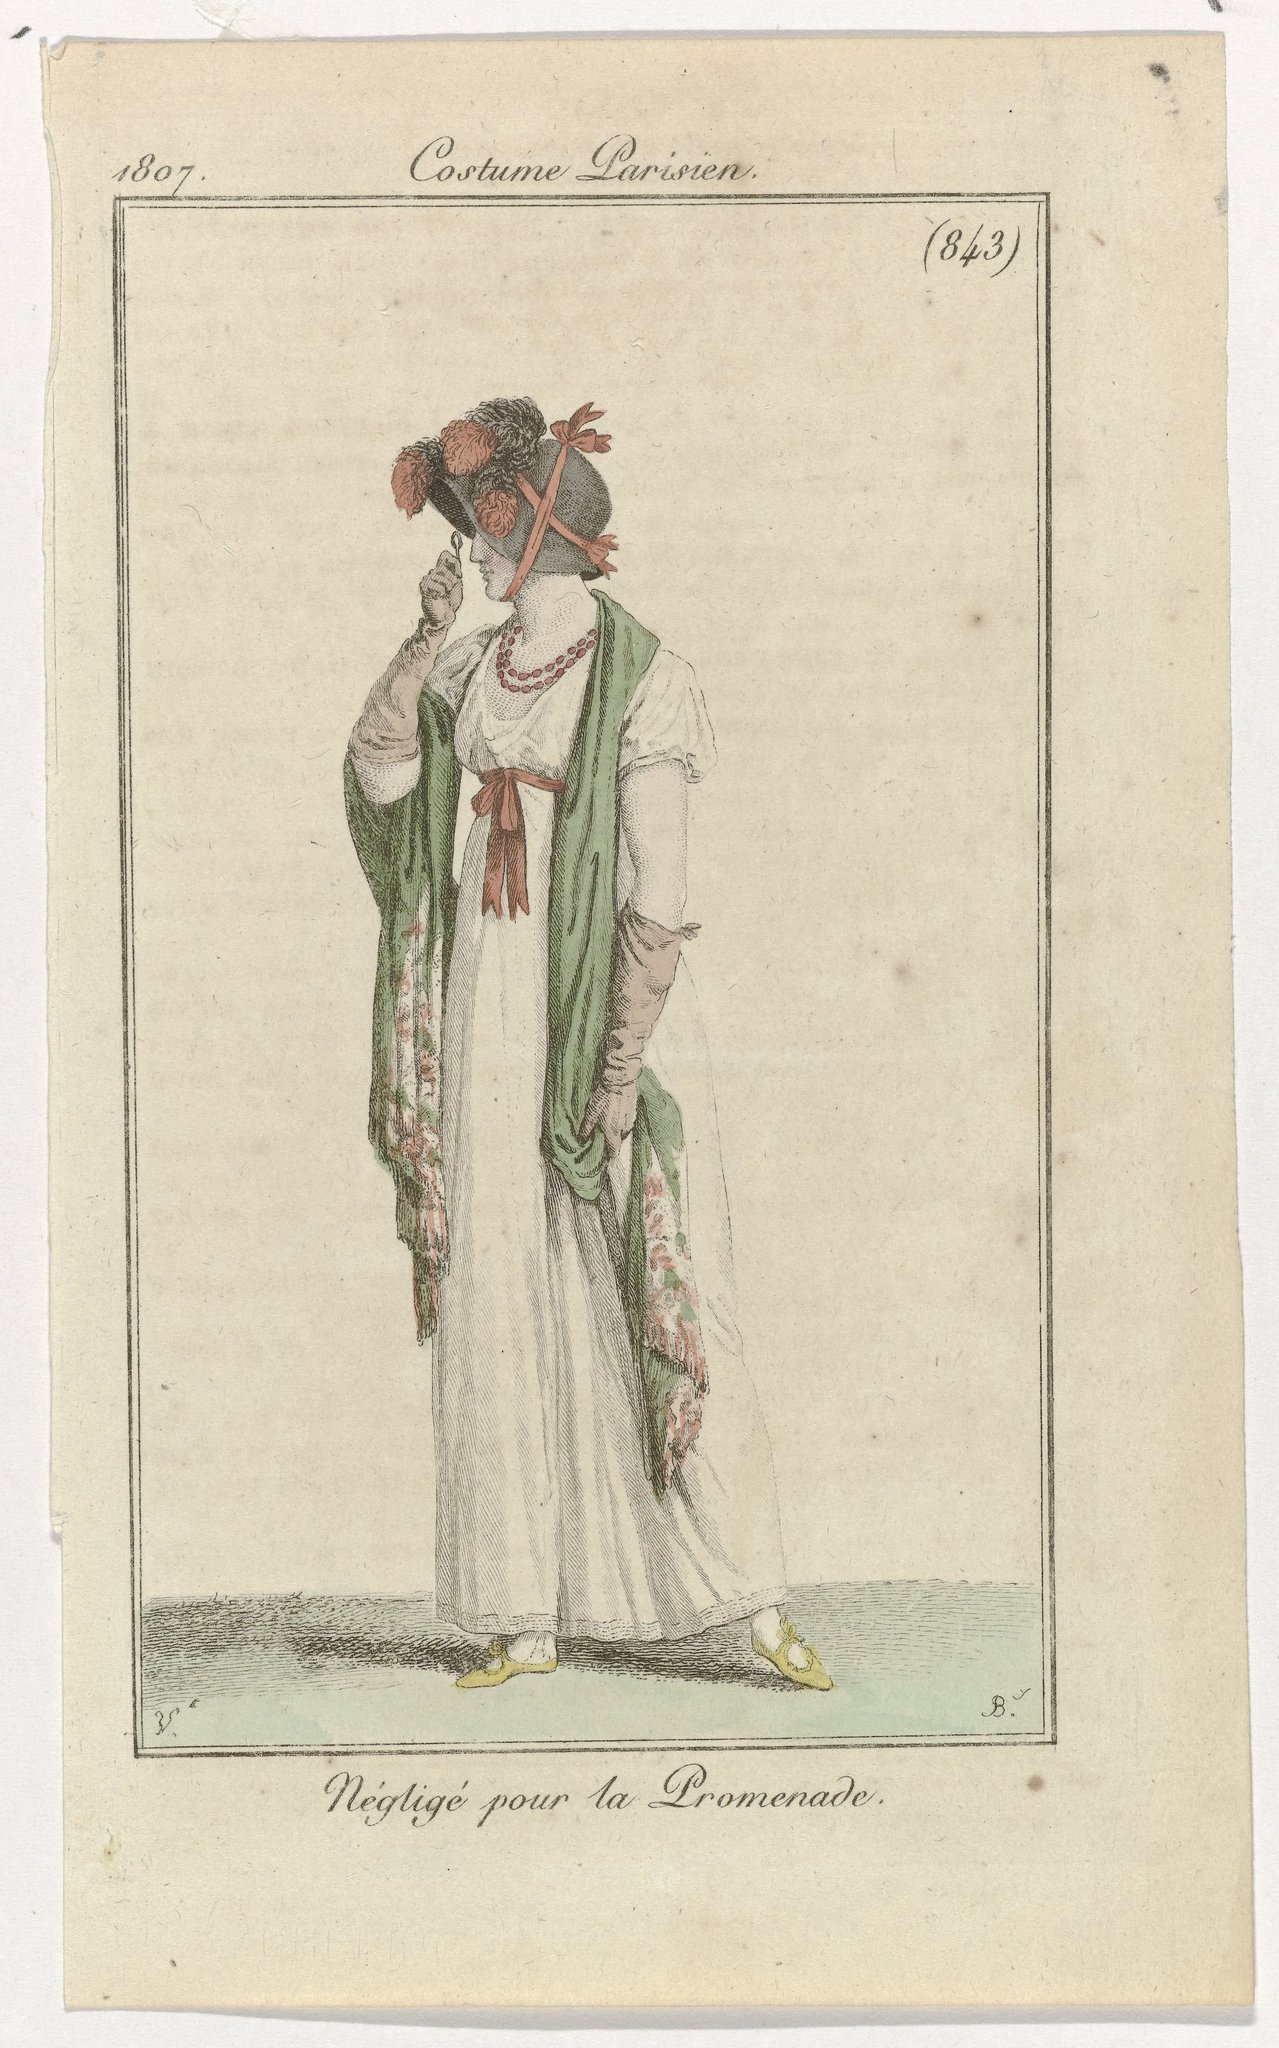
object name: fashion print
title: Journal des Dames et des Modes, Costume Parisien, 15 octobre 1807, (843): Négligé pour la Promenade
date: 1807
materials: paper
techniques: engraving, hand coloring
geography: paris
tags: gloves, mittens (long gloves) (+ women's clothes), clothing for the upper part of the body (shawl) (+ women's clothes), dress, gown: walking dress (+ women's clothes), monocle, single lorgnette - aa - female human figure, fashion plates, head-gear: hat (+ women's clothes), shoes, sandals (+ women's clothes), necklace (+ women's clothes)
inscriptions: title: ‘Costume Parisien.’, caption: ‘Négligé pour la Promenade.’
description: Staande vrouw gekleed in 'négligé pour la Promenade'. Zij draagt een wandeljapon met korte pofmouwen en ceintuur van gestrikt lint. Verdere accessoires: hoed met struisveren, collier bestaande uit twee snoeren, lange handschoenen, lorgnet, lange sjaal afgezet met franjes, platte schoenen met gestrikte banden. De prent maakt deel uit van het modetijdschrift Journal des Dames et des Modes, uitgegeven door Pierre de la Mésangère, Parijs, 1797-1839.